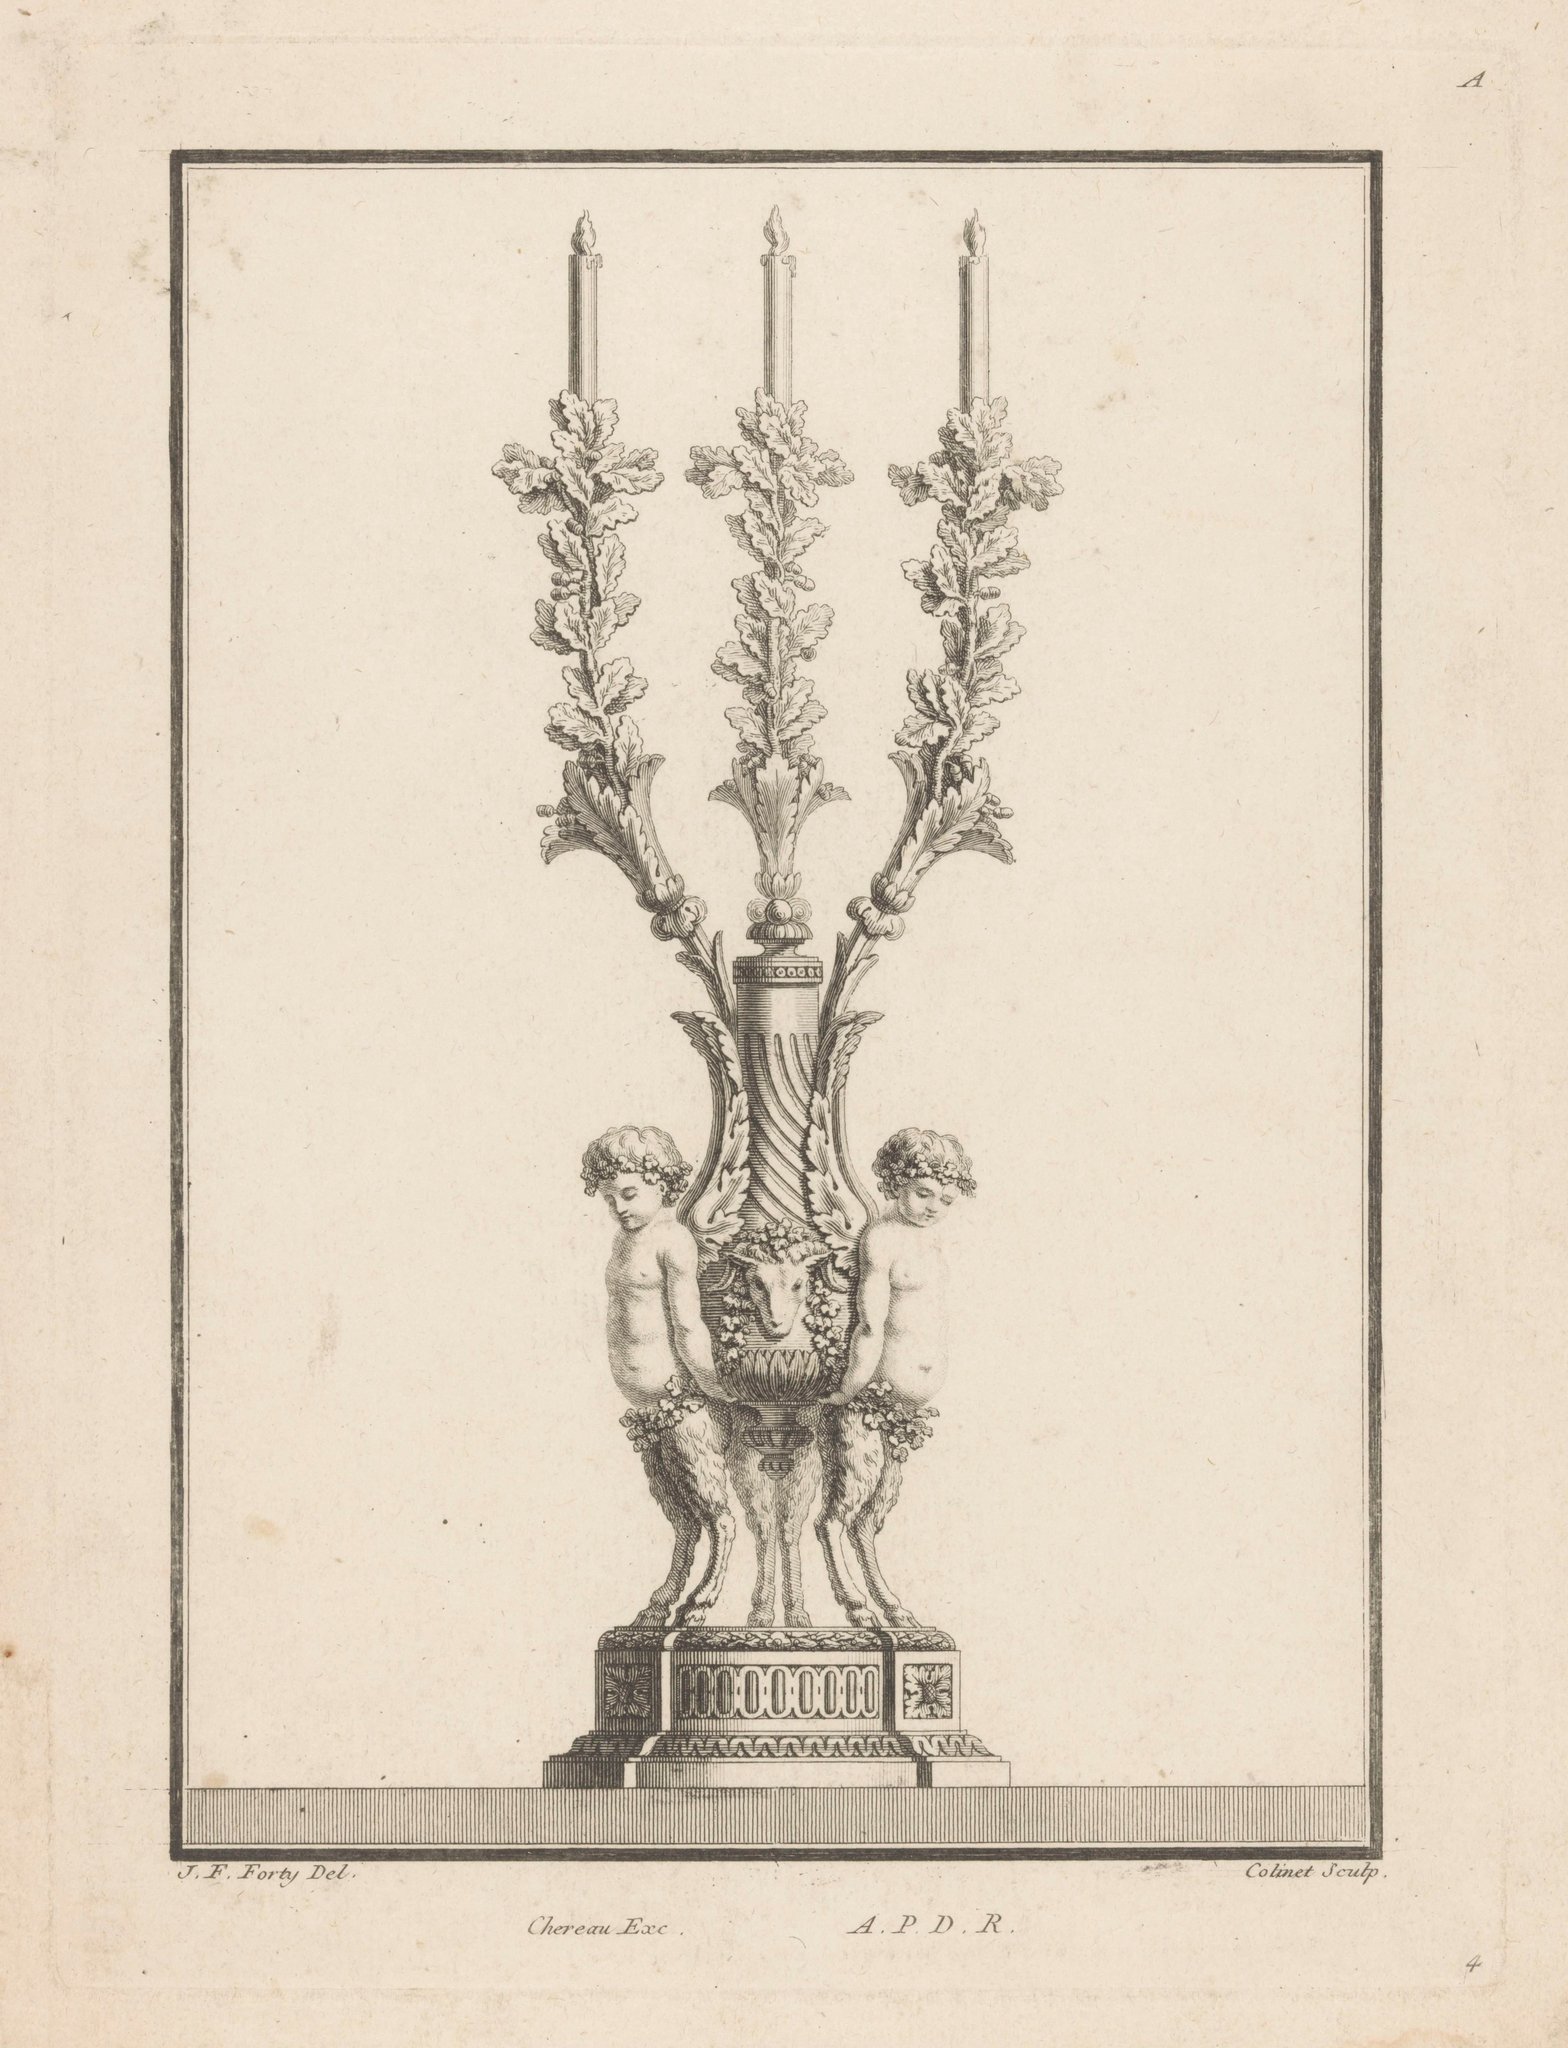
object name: print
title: A Cahier de six Girandoles à l'usage des Orfévres et des Fondeurs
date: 1775-1790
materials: paper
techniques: engraving, etching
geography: paris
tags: chandelier, candelabrum, cupids: 'amores', 'amoretti', 'putti'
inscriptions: collector's mark: Lugt 2228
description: Een geornamenteerde driearmige girandole met ranken en twee gevleugelde putti op bokkenpoten.